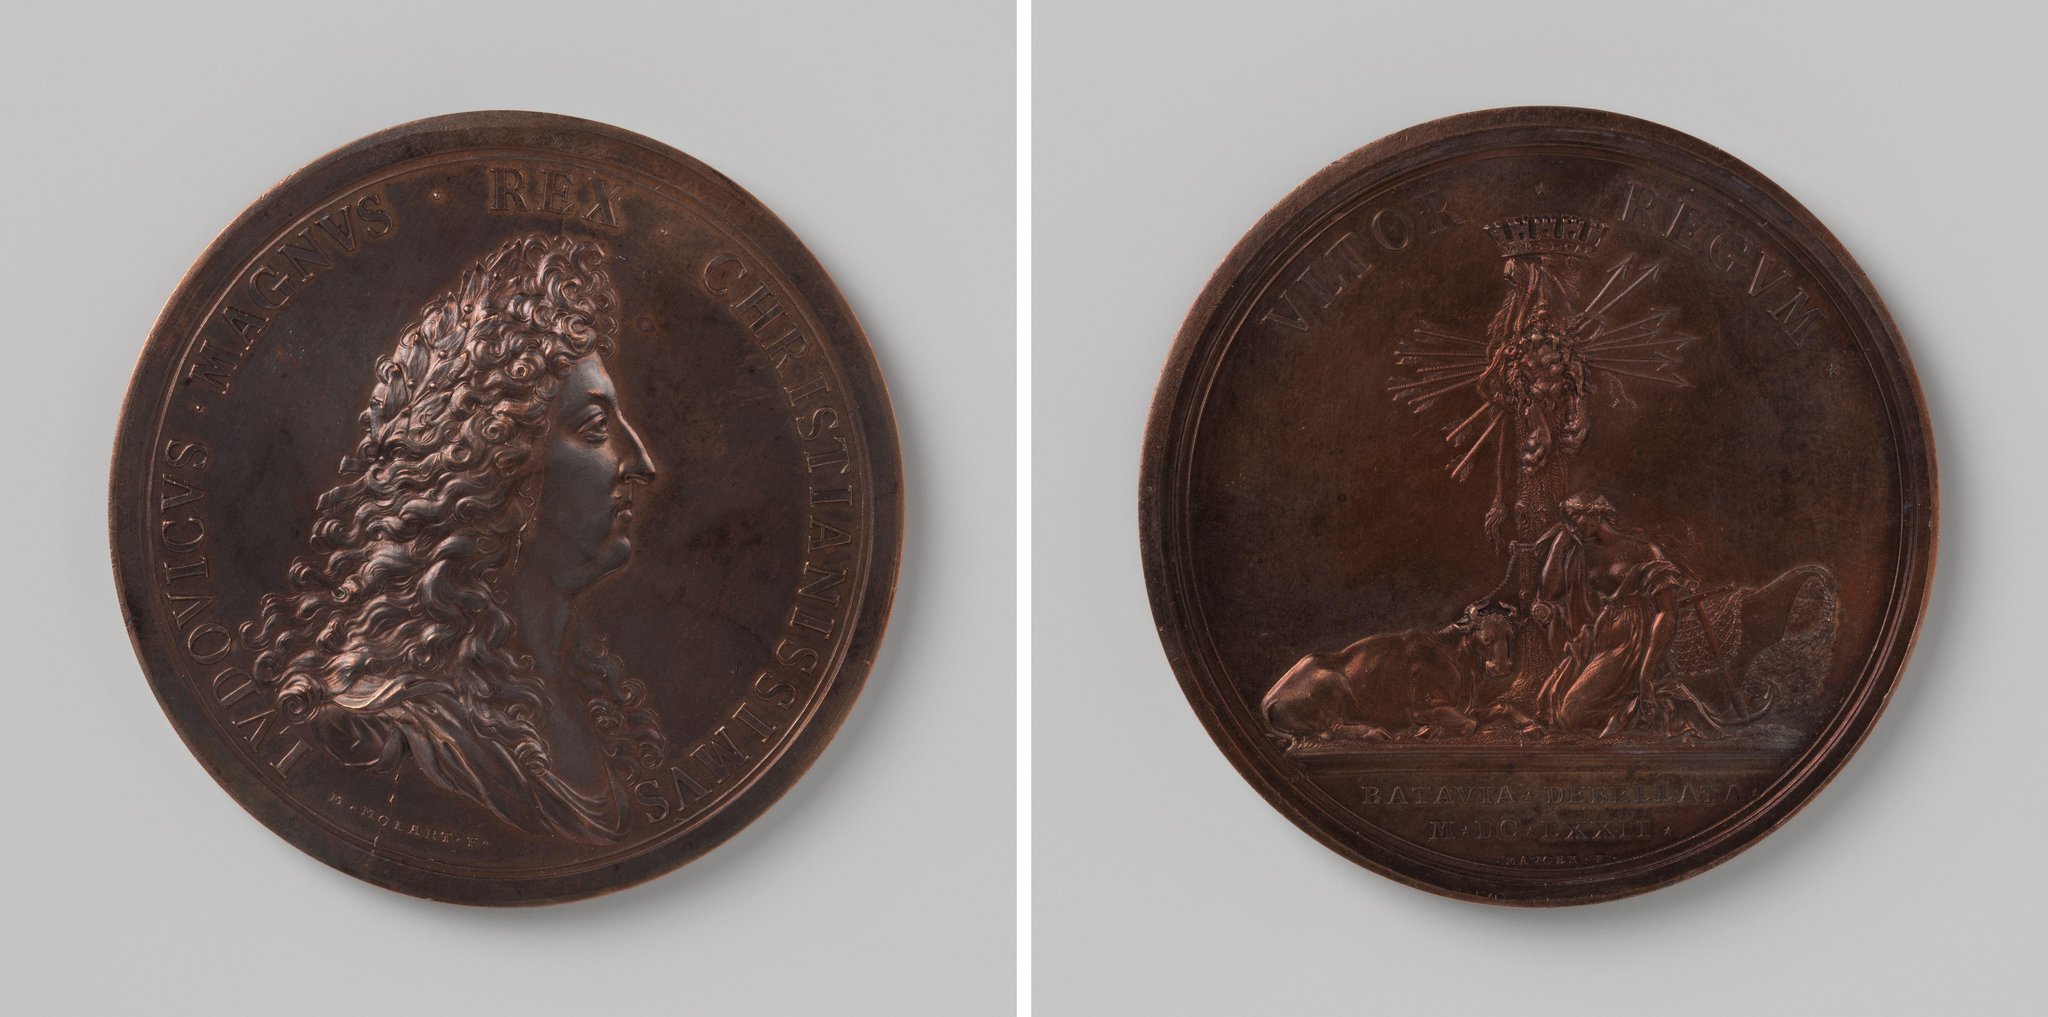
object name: history medal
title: De Nederlanden door Frankrijk overwonnen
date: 1672-1722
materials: bronze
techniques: striking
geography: paris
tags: lodewijk xiv (koning van frankrijk), utrecht, gelderland, rampjaar (disaster year)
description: Bronzen penning. Voorzijde: borststuk man (Lodewijk XIV) met lauwerkrans binnen omschrift. Keerzijde: treurende Nederlanden met anker gezeten bij bekroonde paal waaraan leeuwehuid en bundel van zeven pijlen hangen binnen omschrift.